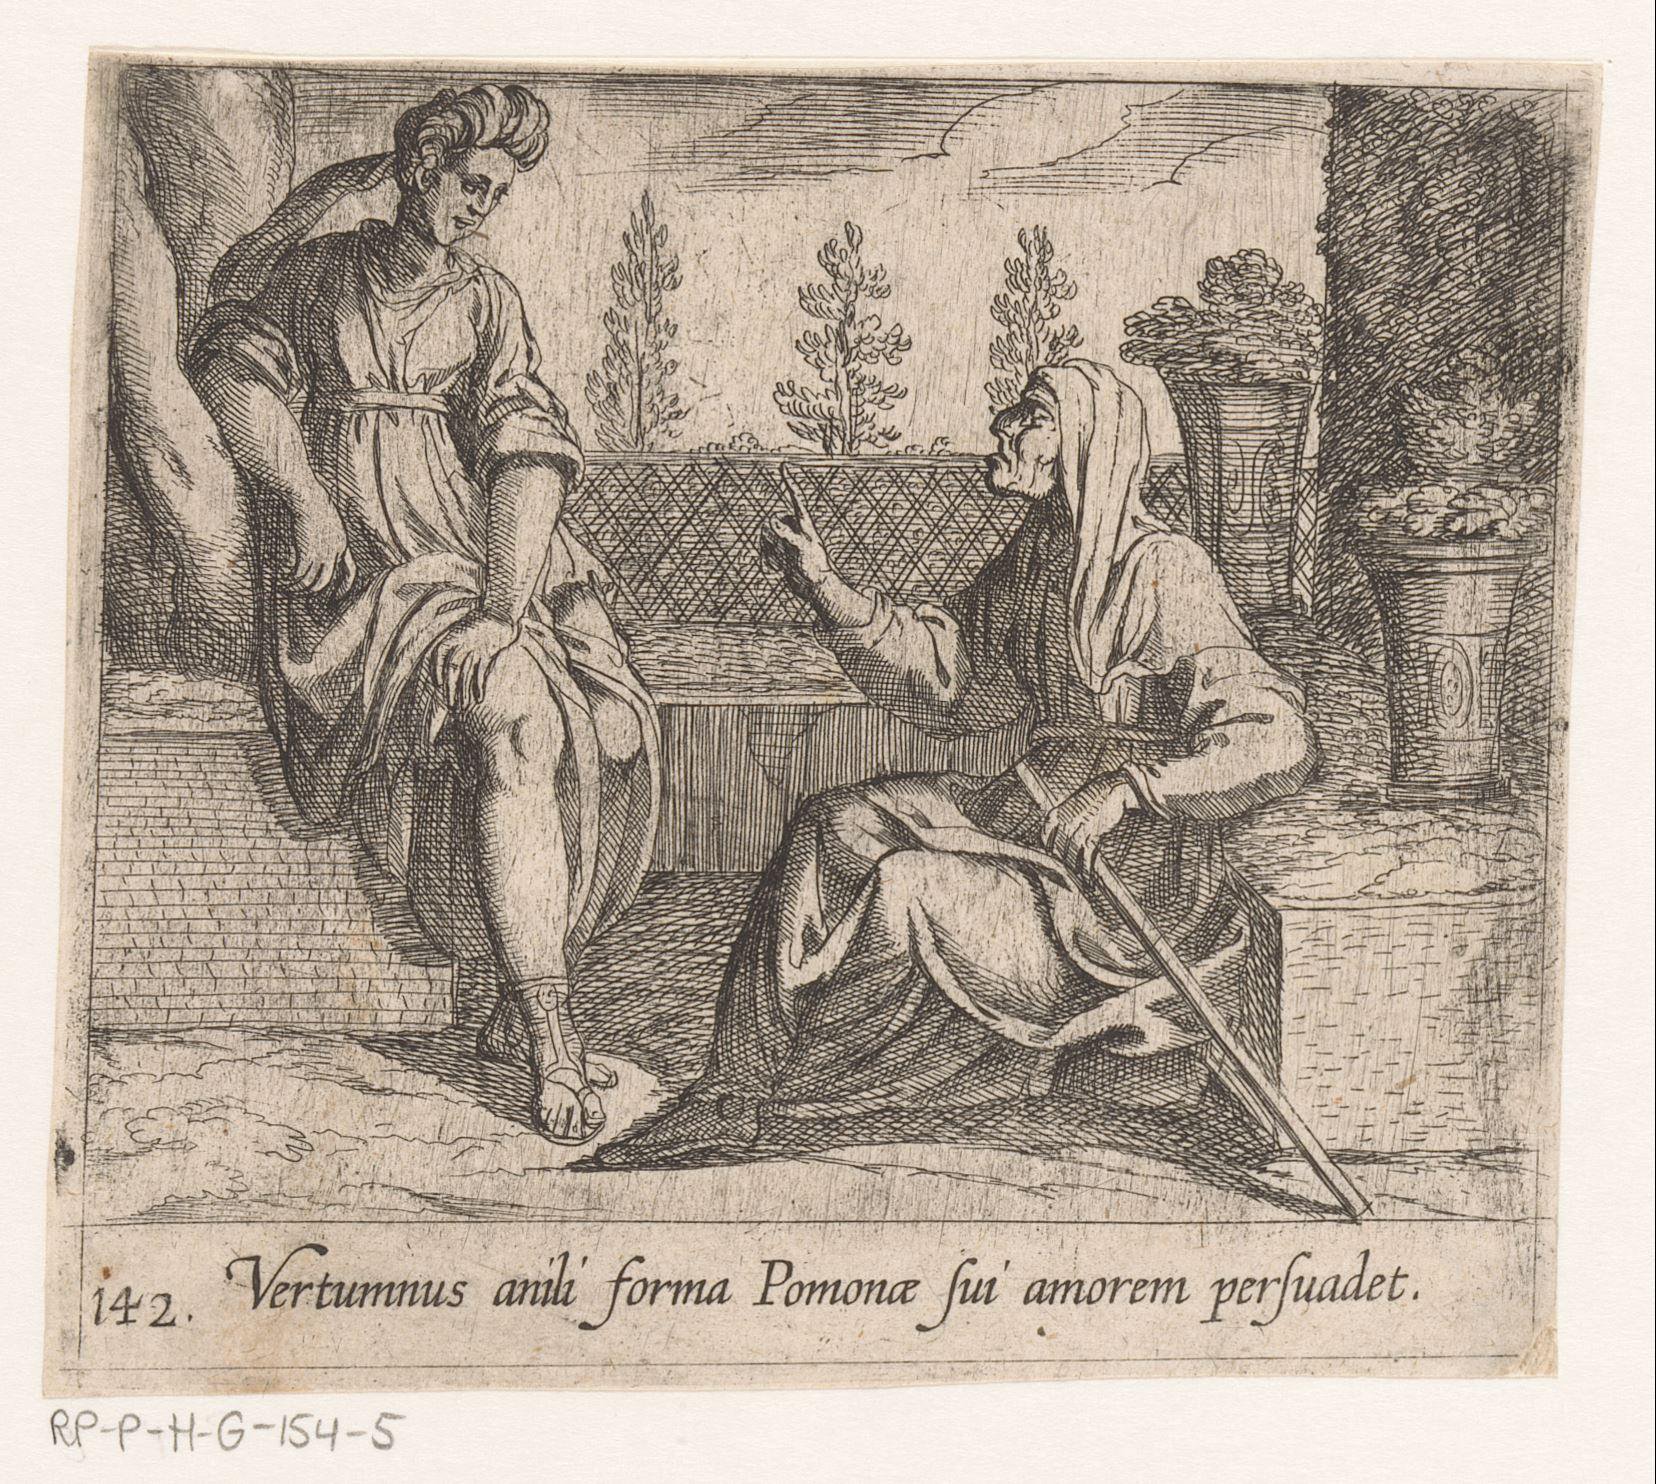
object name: print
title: Metamorfosen van Ovidius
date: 1606-1638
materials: paper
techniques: etching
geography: italy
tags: vertumnus and pomona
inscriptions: collector's mark: ‘Hinloopen’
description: Pomona zit onder een boom. De Italiaanse god Vertumnus maakt haar in de gedaante van een oude vrouw het hof. Titel in het Latijn in ondermarge.